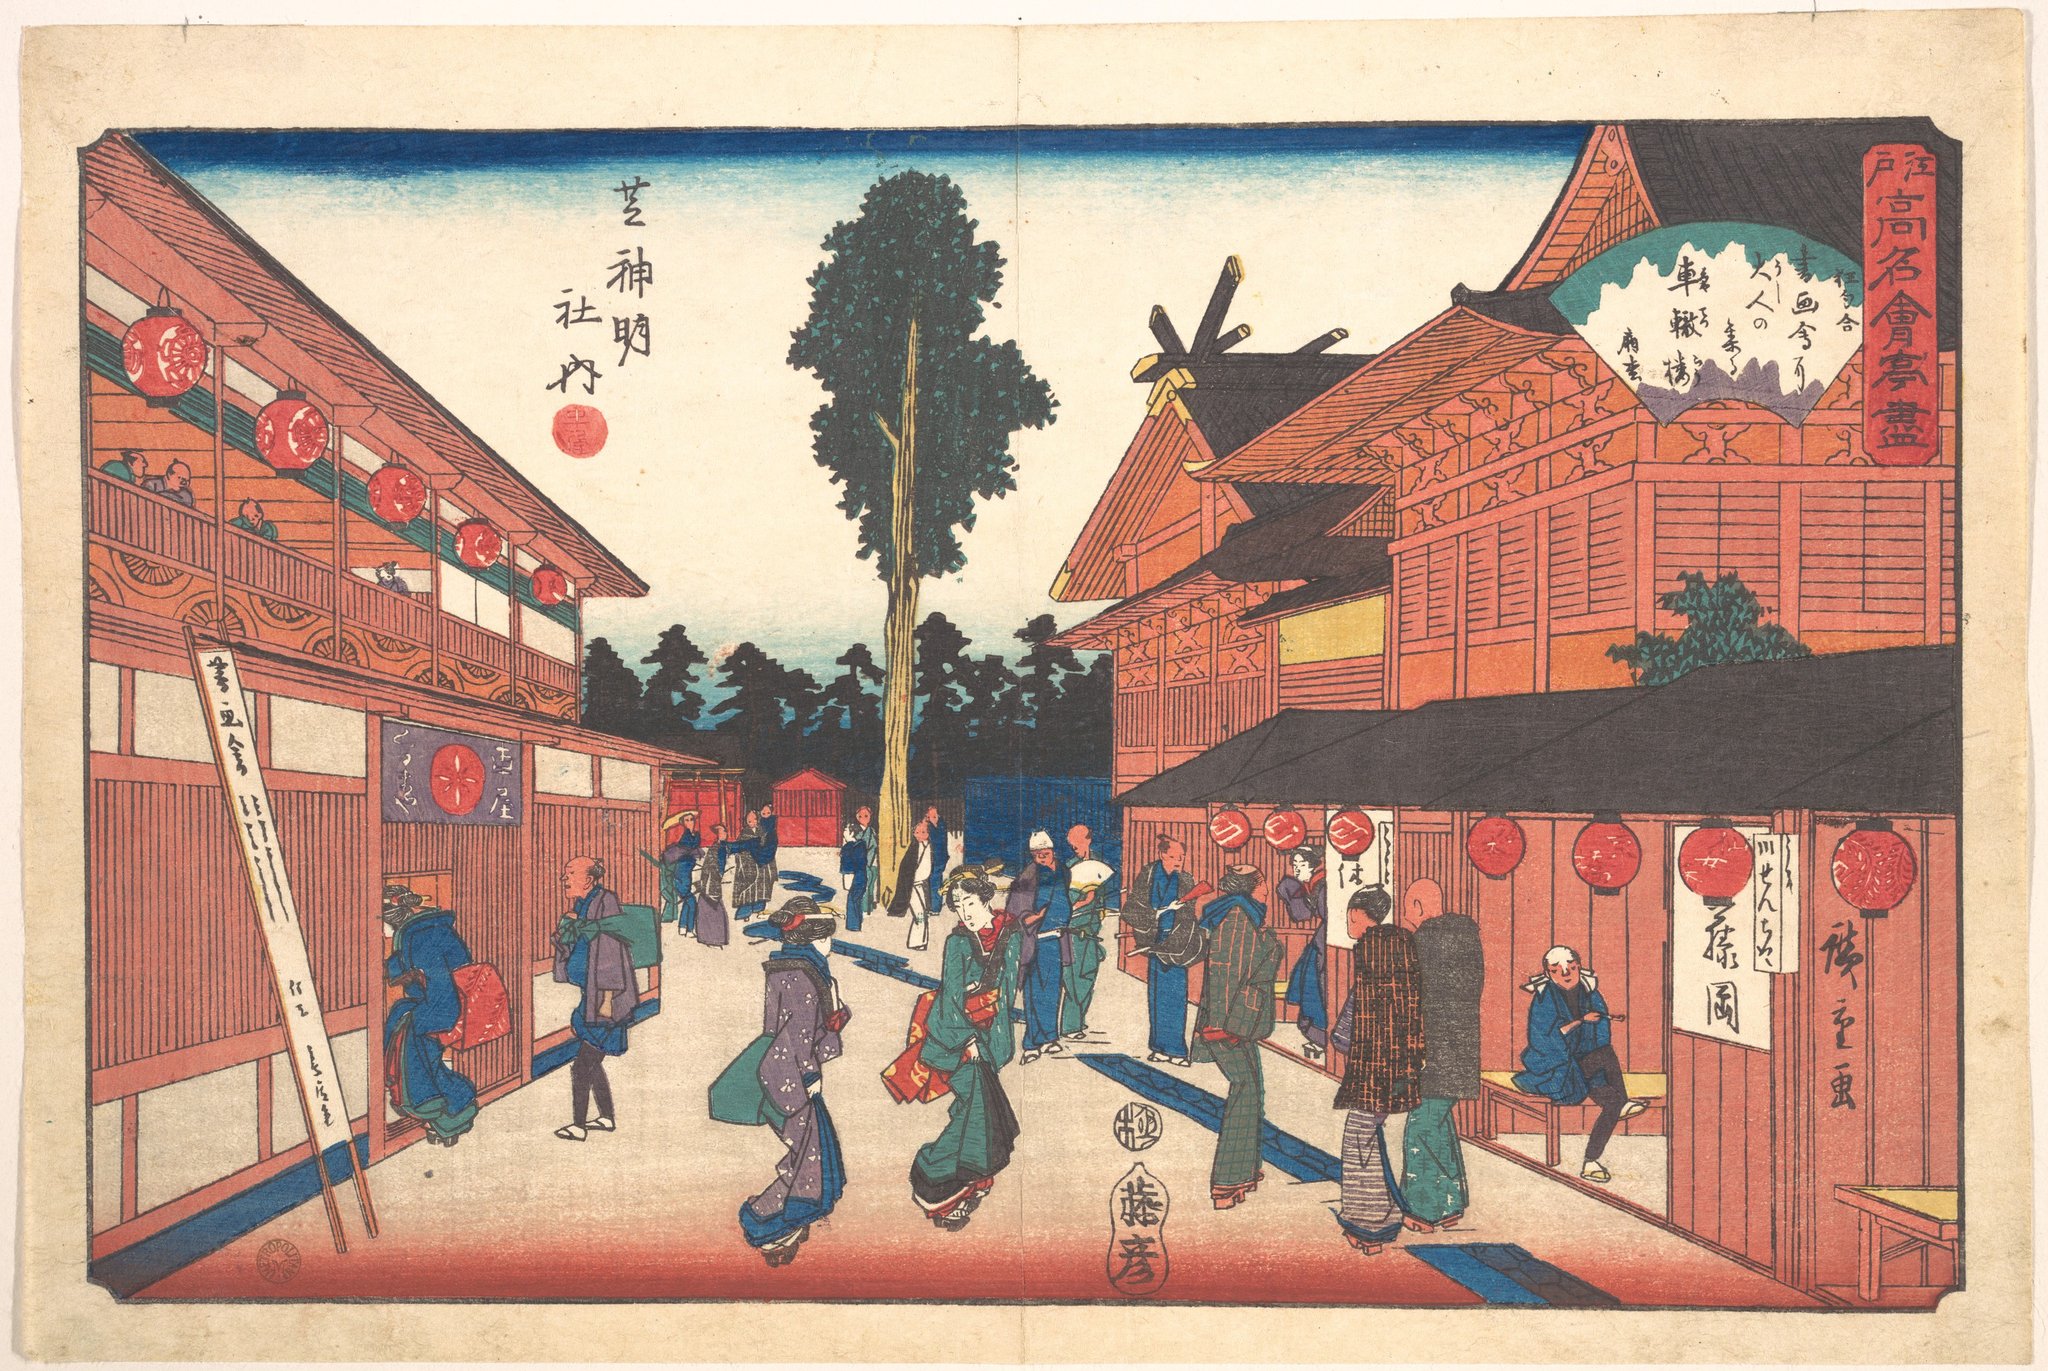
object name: print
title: Shiba Shinmeisha Uchi (Shatetsu-ro)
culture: japanese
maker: utagawa hiroshige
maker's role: artist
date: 1840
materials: ink, paper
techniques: woodblock print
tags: buildings,streets,men,women,walking